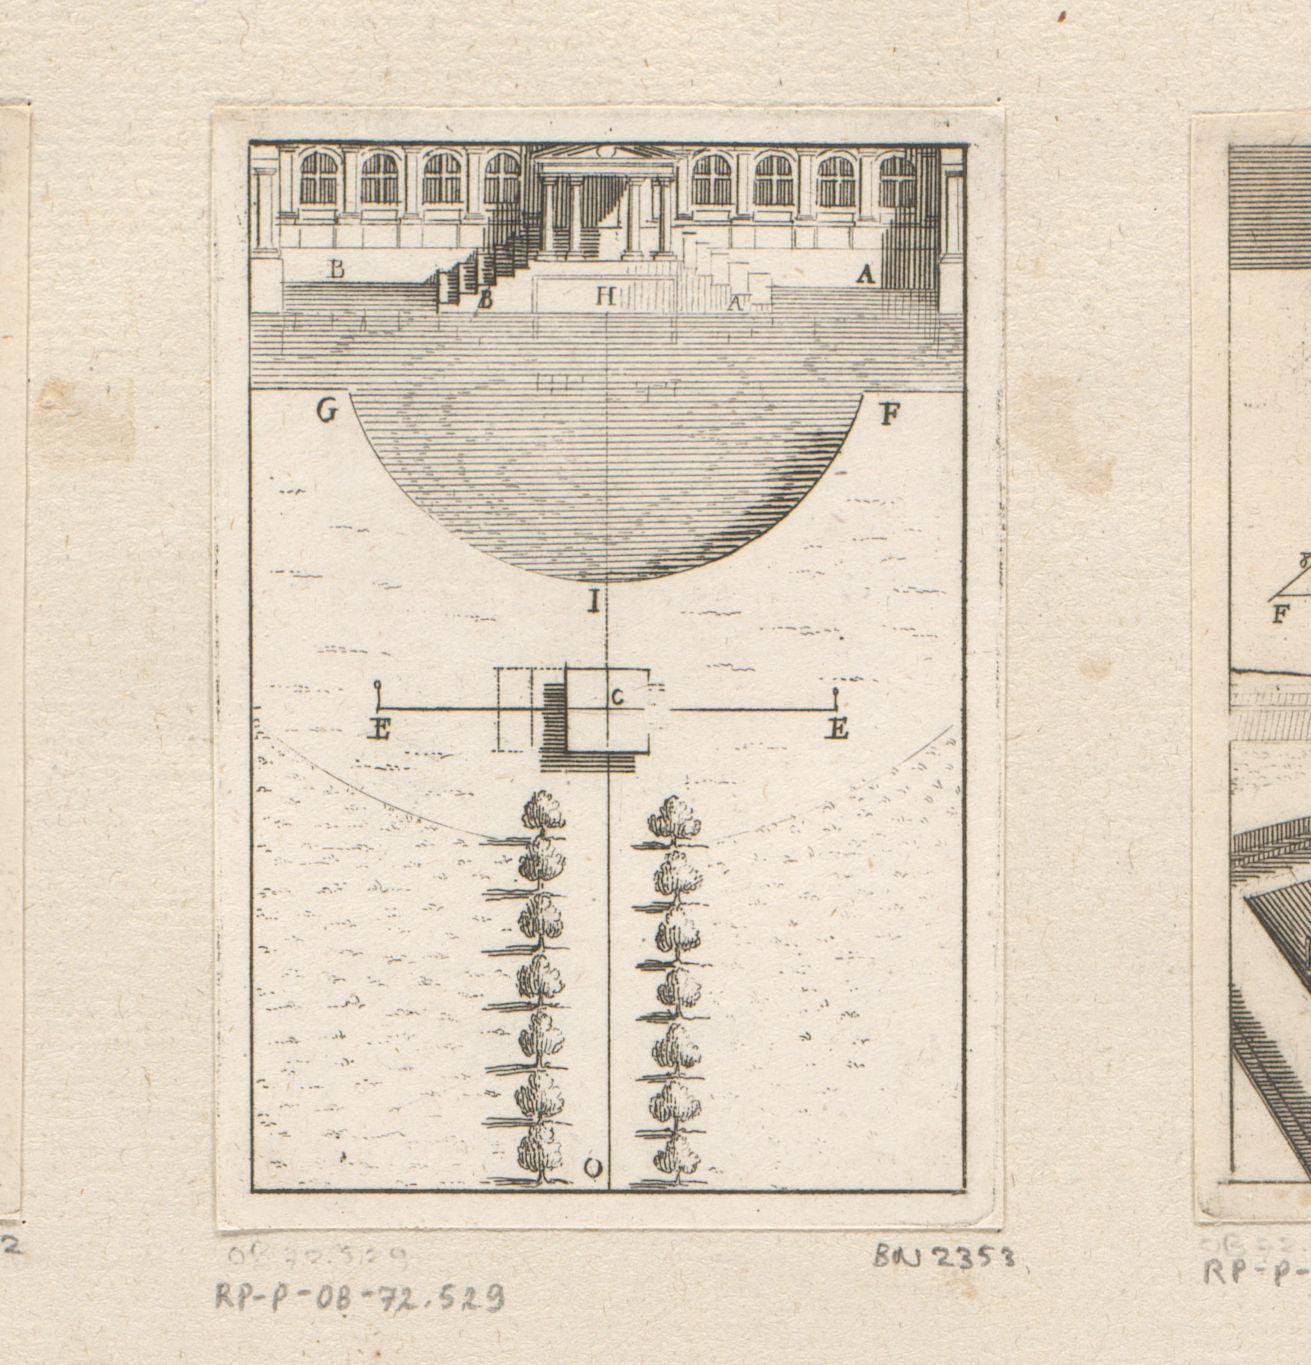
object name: print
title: Uitmeten van een bomenrij voor de ingang van een kasteel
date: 1669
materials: paper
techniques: etching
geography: paris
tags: castle, french or architectonic garden; formal garden, planimetry, geometry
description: Prent toegevoegd aan: Pratique de la géometrie, sur le papier et sur le terrain. Avec un nouvel ordre et une méthode particulière. Parijs: Thomas Jolly, 1669.